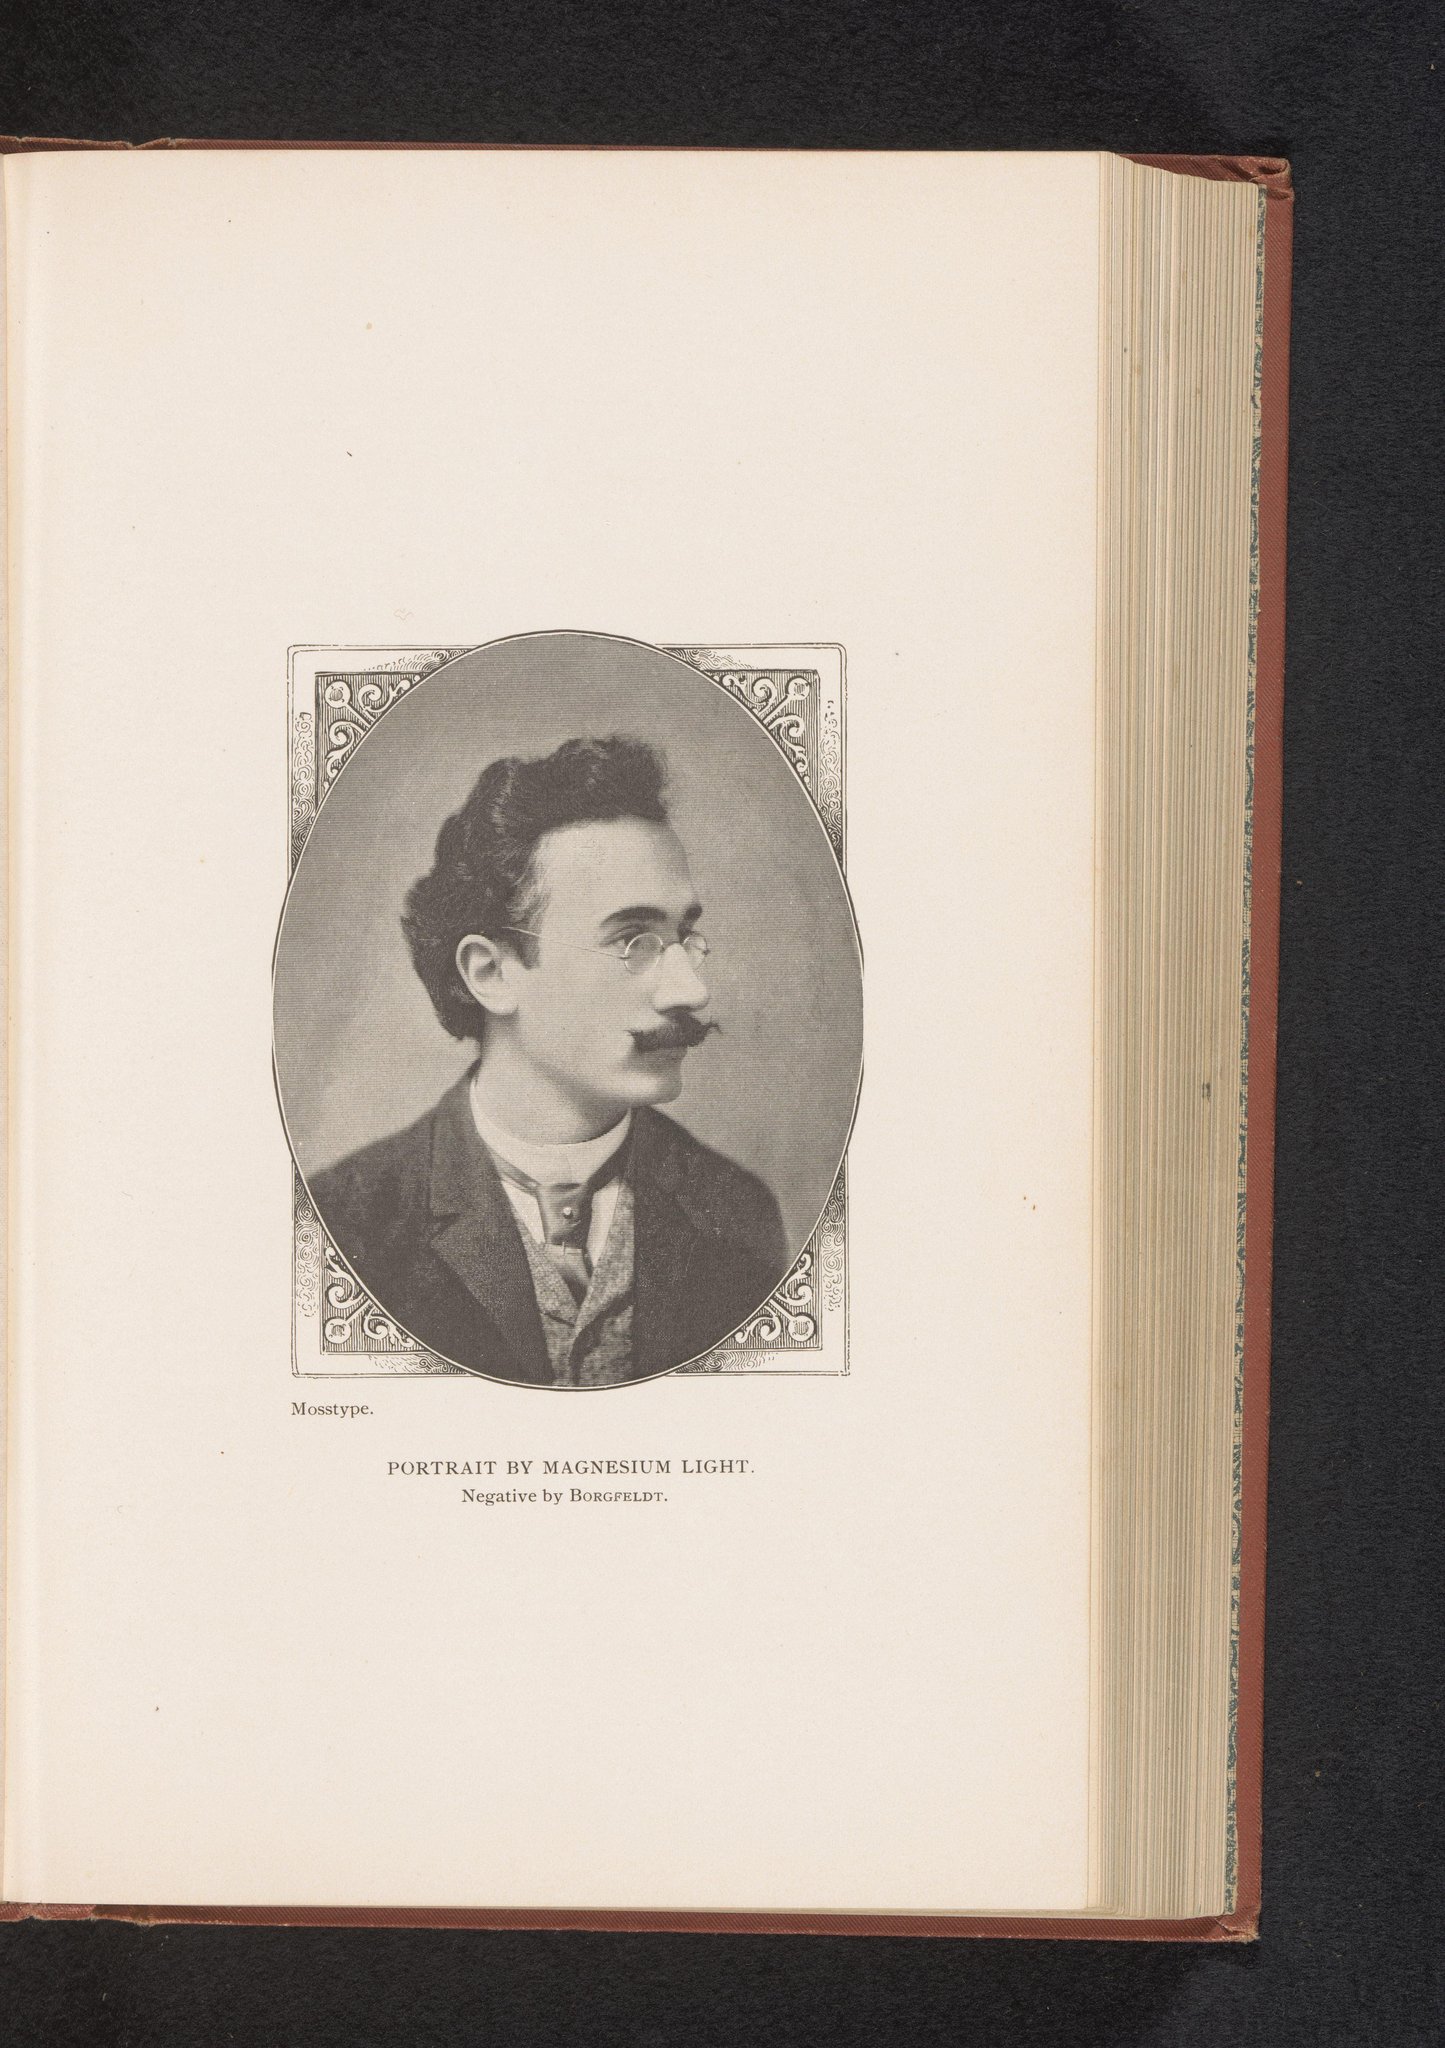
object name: page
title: Portret van een onbekende man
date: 1884-1889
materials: paper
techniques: autotype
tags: historical persons not known by name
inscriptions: inscription: ‘Mosstype.’